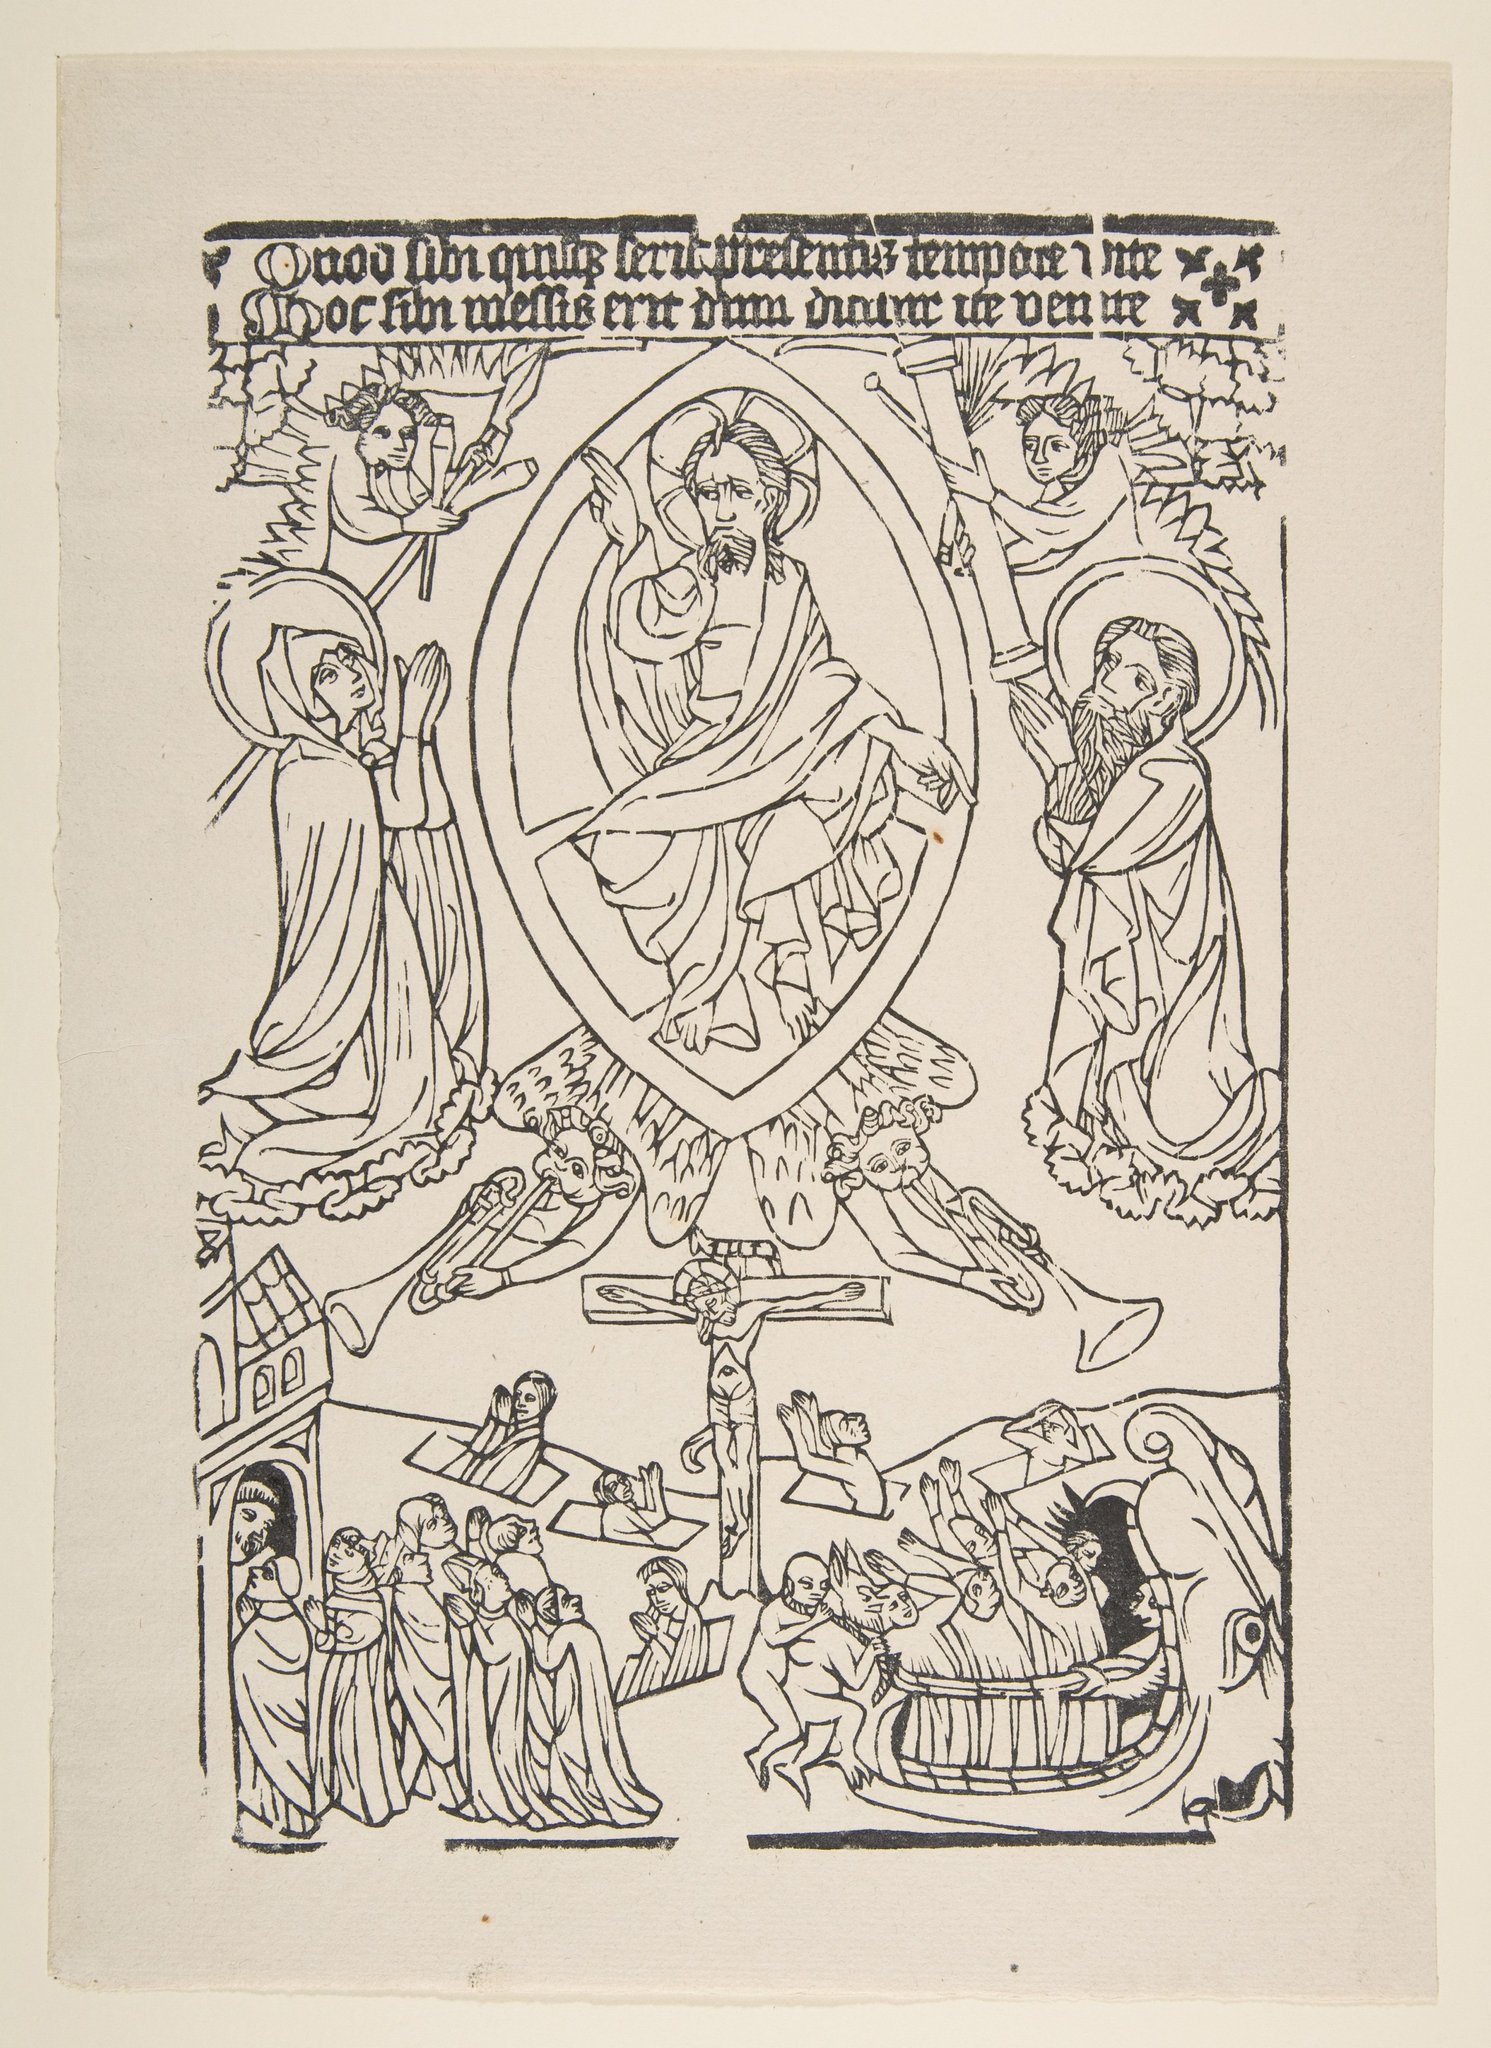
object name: print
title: The Last Judgment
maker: anonymous, german, 15th century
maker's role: artist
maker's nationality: german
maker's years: 1400-1500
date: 1401-1500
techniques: woodcut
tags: men,women,christ,last judgement